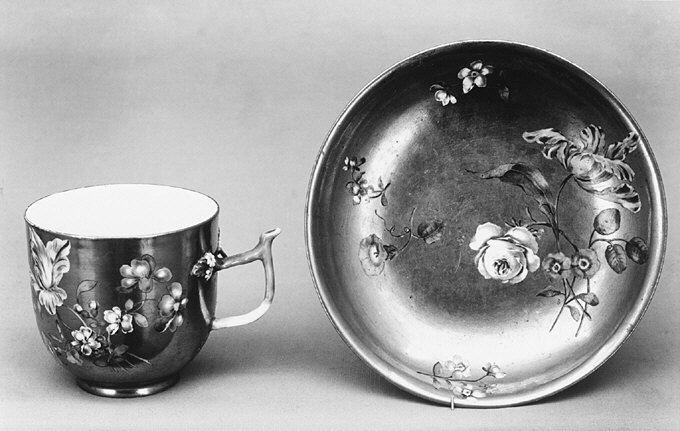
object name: cup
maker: meissen manufactory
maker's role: manufactory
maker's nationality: german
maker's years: 1710-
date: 1701-1800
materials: hard paste porcelain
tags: flowers